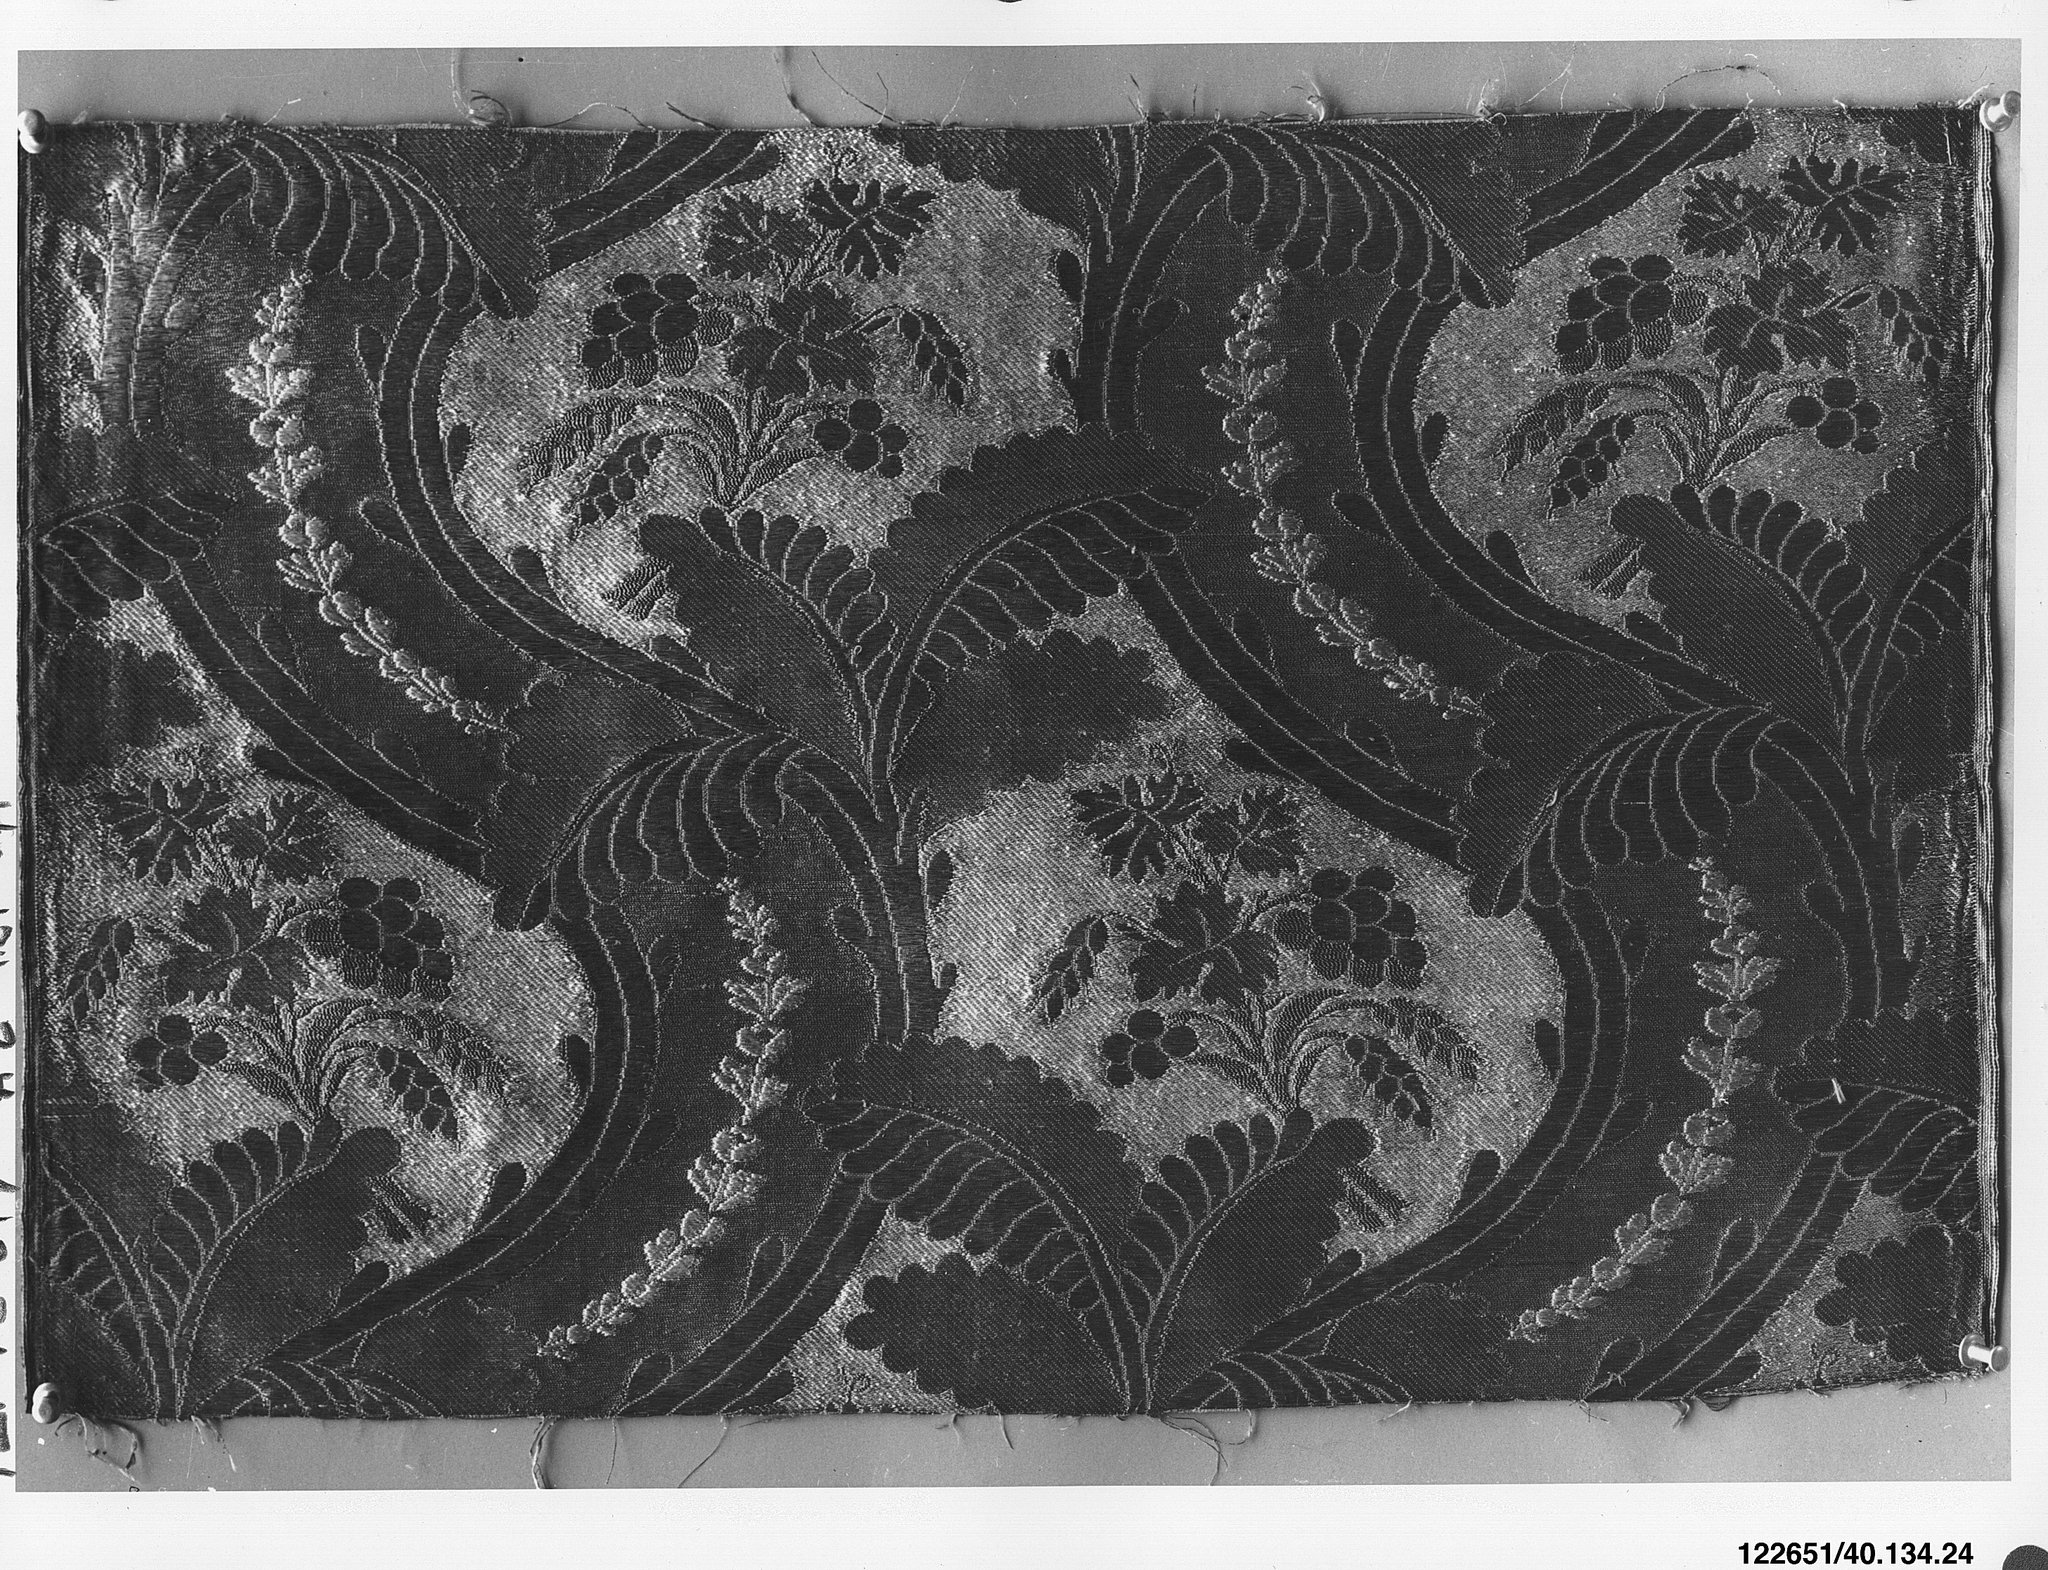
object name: piece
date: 1701-1900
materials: metal thread, silk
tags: leaves